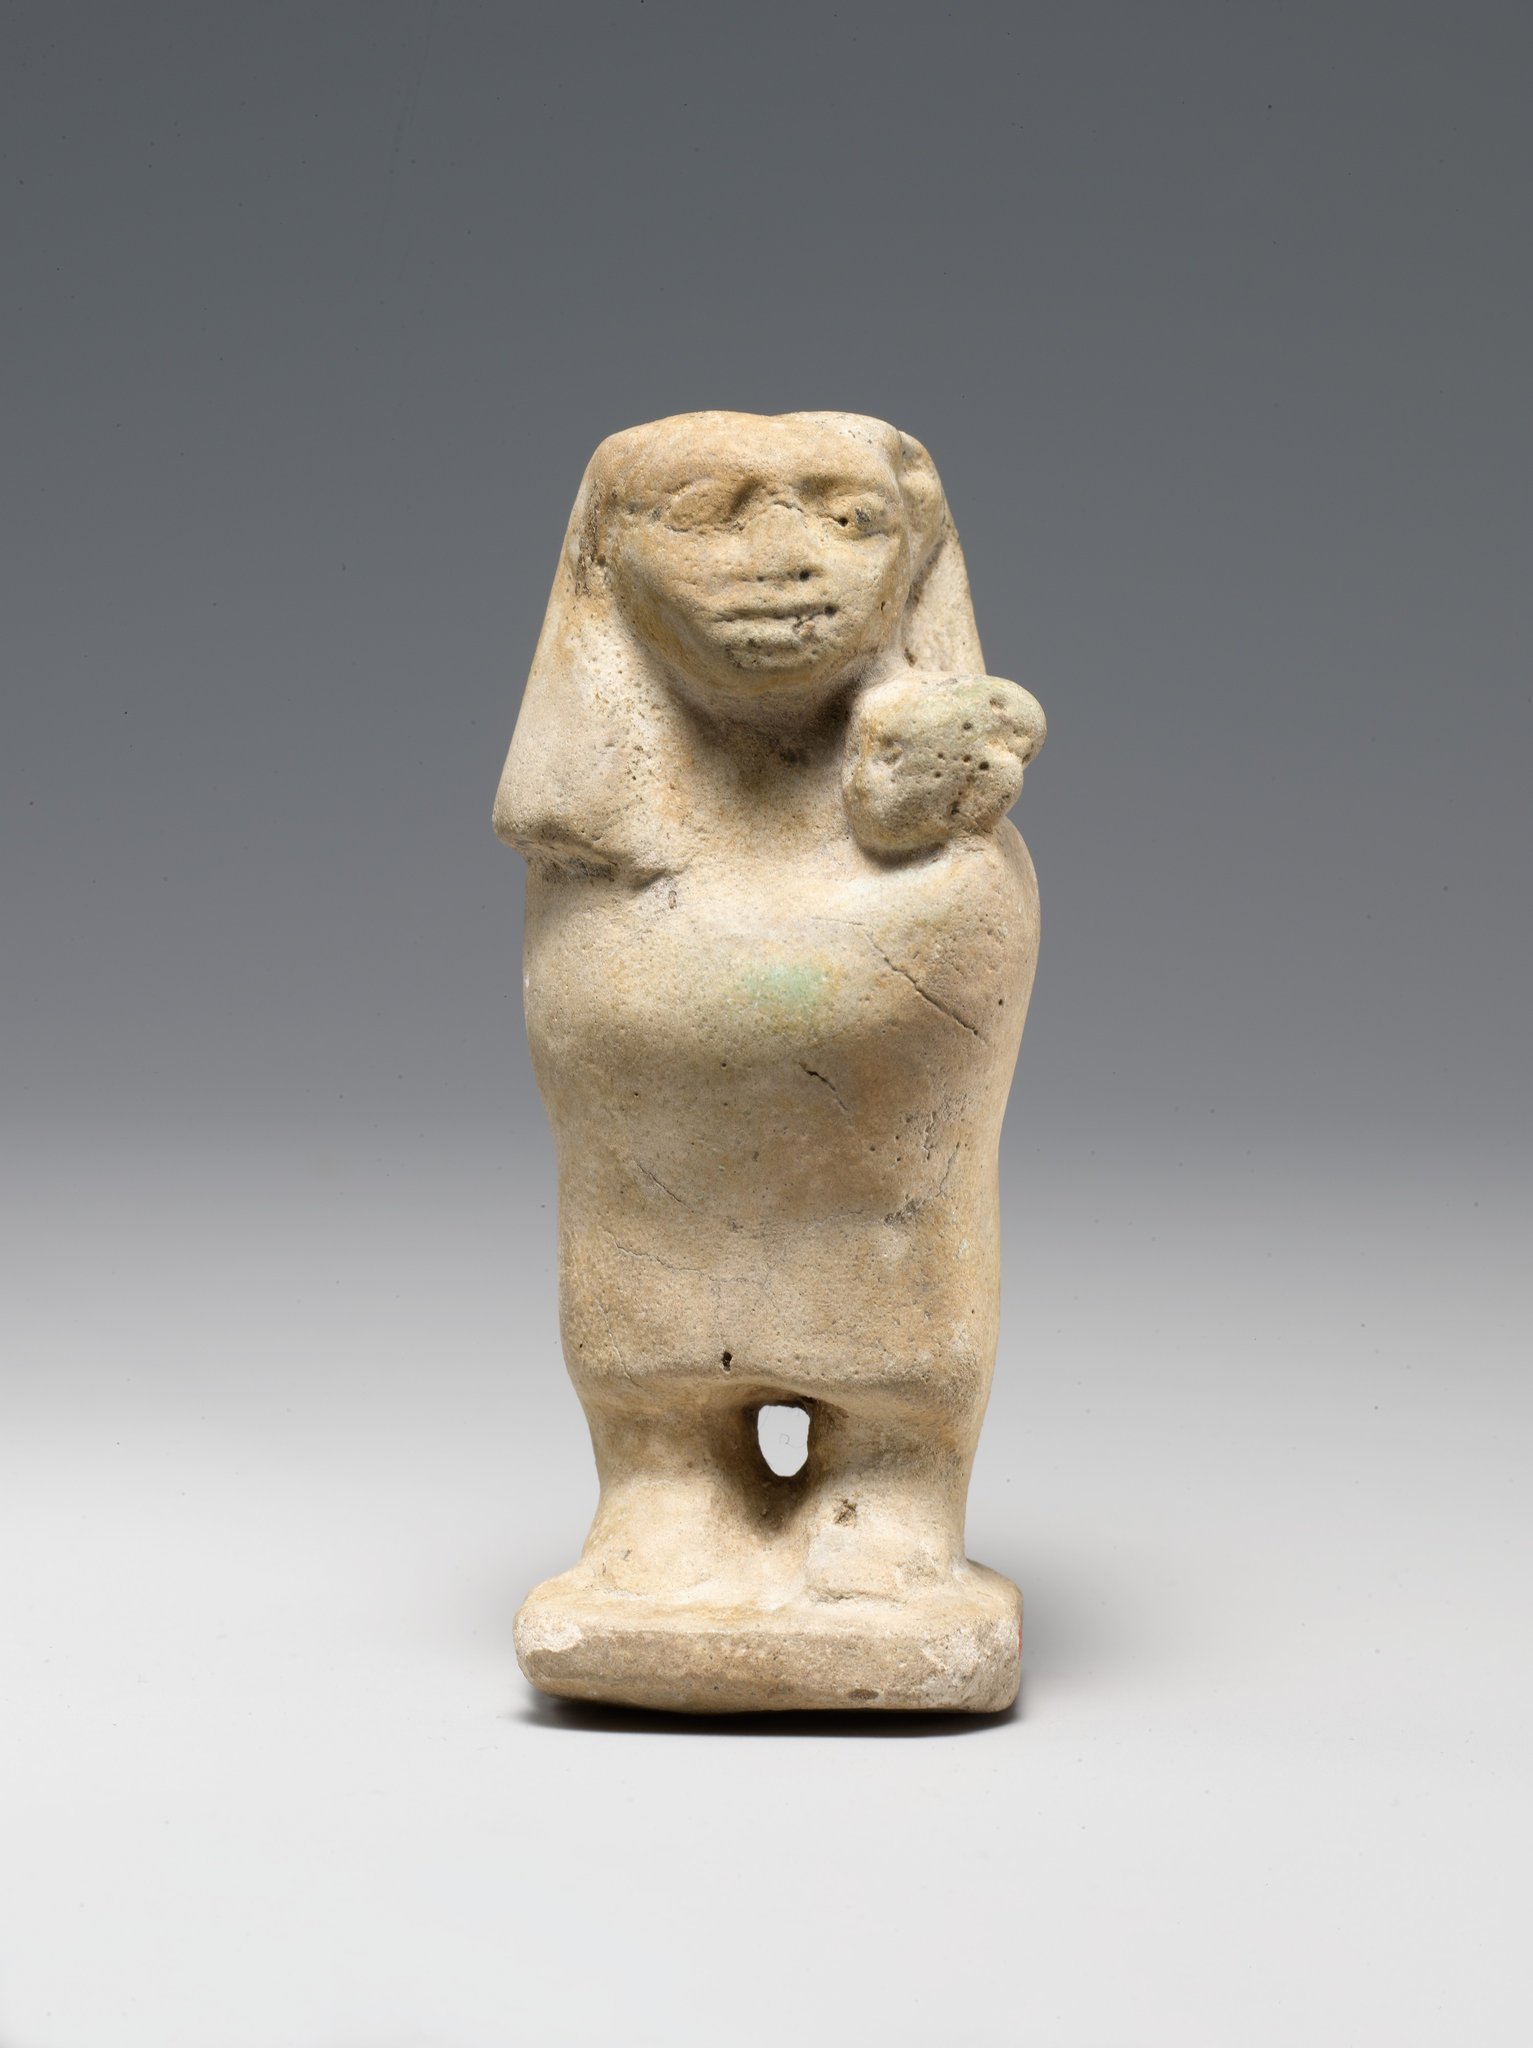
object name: figurine, woman with baby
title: Figurine of a Woman with Her Baby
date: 1961-1917 BCE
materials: faience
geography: egypt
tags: infants,women